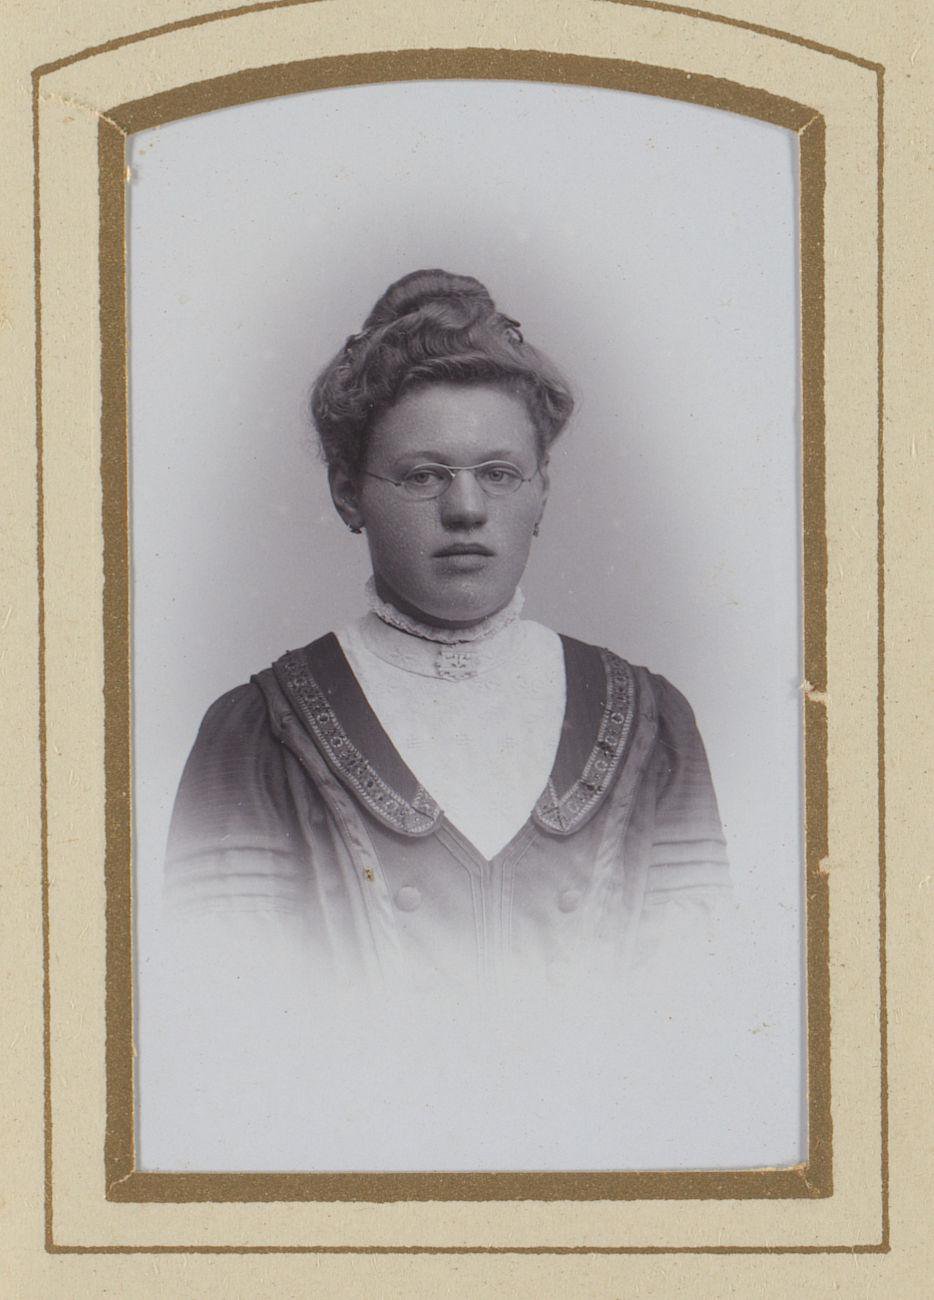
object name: carte de visite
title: Portret van een jonge vrouw met bril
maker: johannes laurens theodorus huijsen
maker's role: fotograaf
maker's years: 1852-1910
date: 1883-1910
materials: cardboard, photographic support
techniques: collodion silver print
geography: hoorn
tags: eyeglasses, spectacles, adolescent, young woman, maiden, historical persons - bb - woman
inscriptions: inscription: ‘J.L.T. HUIJSEN/ Photographe/ Bekroond op verschillende/ Tentoonstellingen/ HOORN/ Ramen 17./ De plaat blijft ter nabestelling bewaard.’